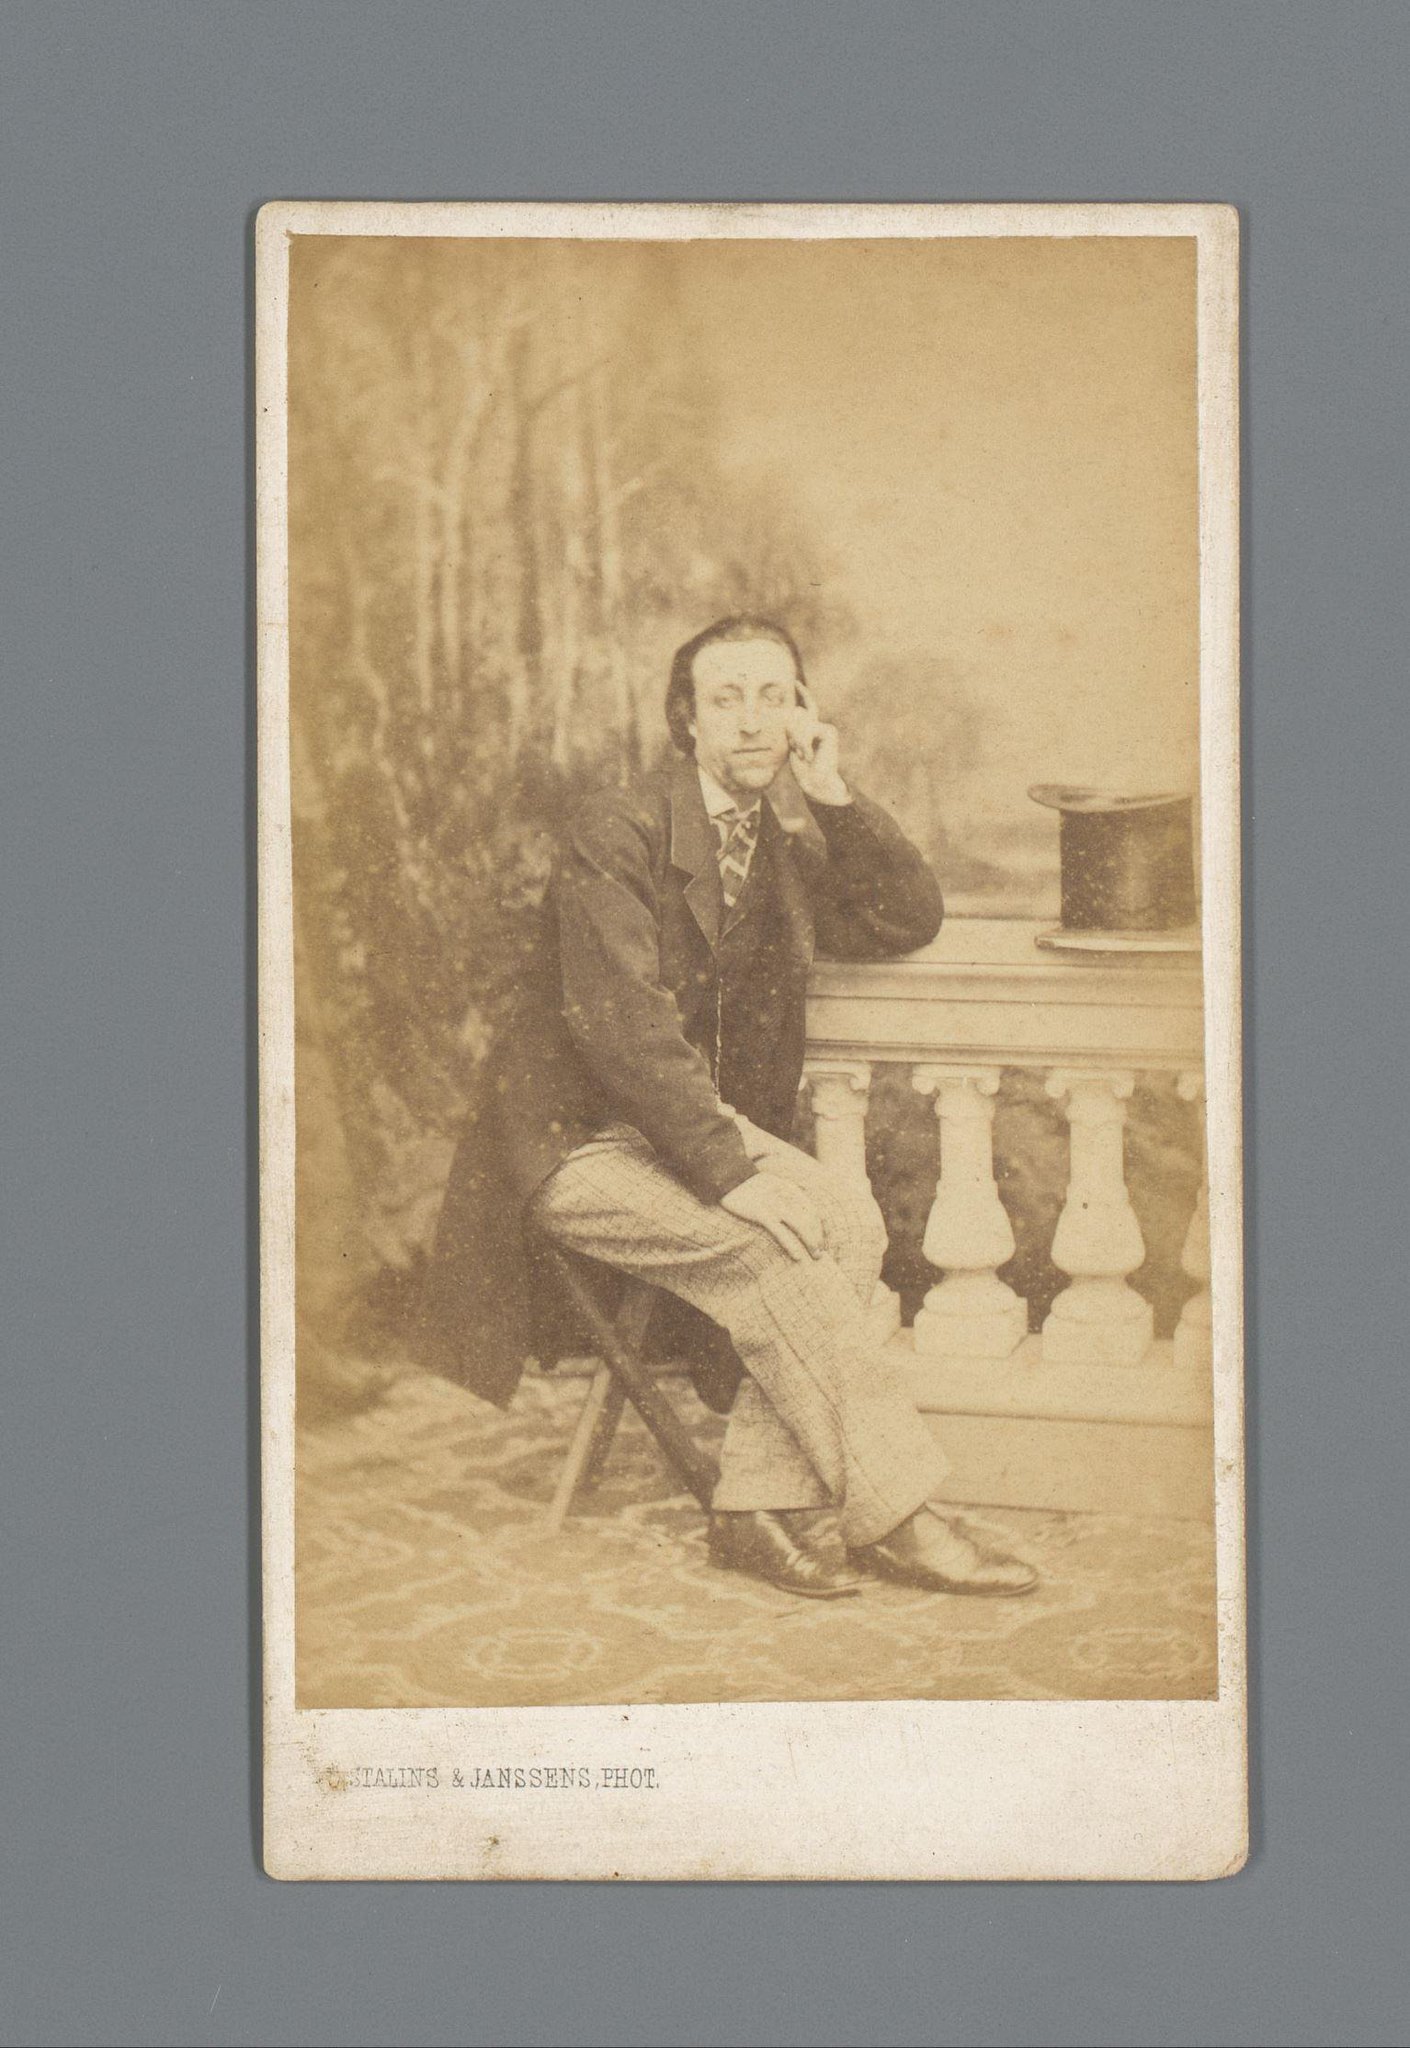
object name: carte de visite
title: Portret van de schilder Edouard Moerenhout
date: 1866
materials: cardboard, paper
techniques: albumen print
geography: antwerp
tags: painter, historical persons, portrait, self-portrait of painter, antwerp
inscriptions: inscription: ‘Edouard Moerenhout (peintre)/ 1866.’, inscription: ‘Stalins & Janssens, Phot.’, inscription: ‘Etablissement Photographique/ de/ Stalins & Janssens/ 38, Rempart du Lombard, 38/ Anvers.’